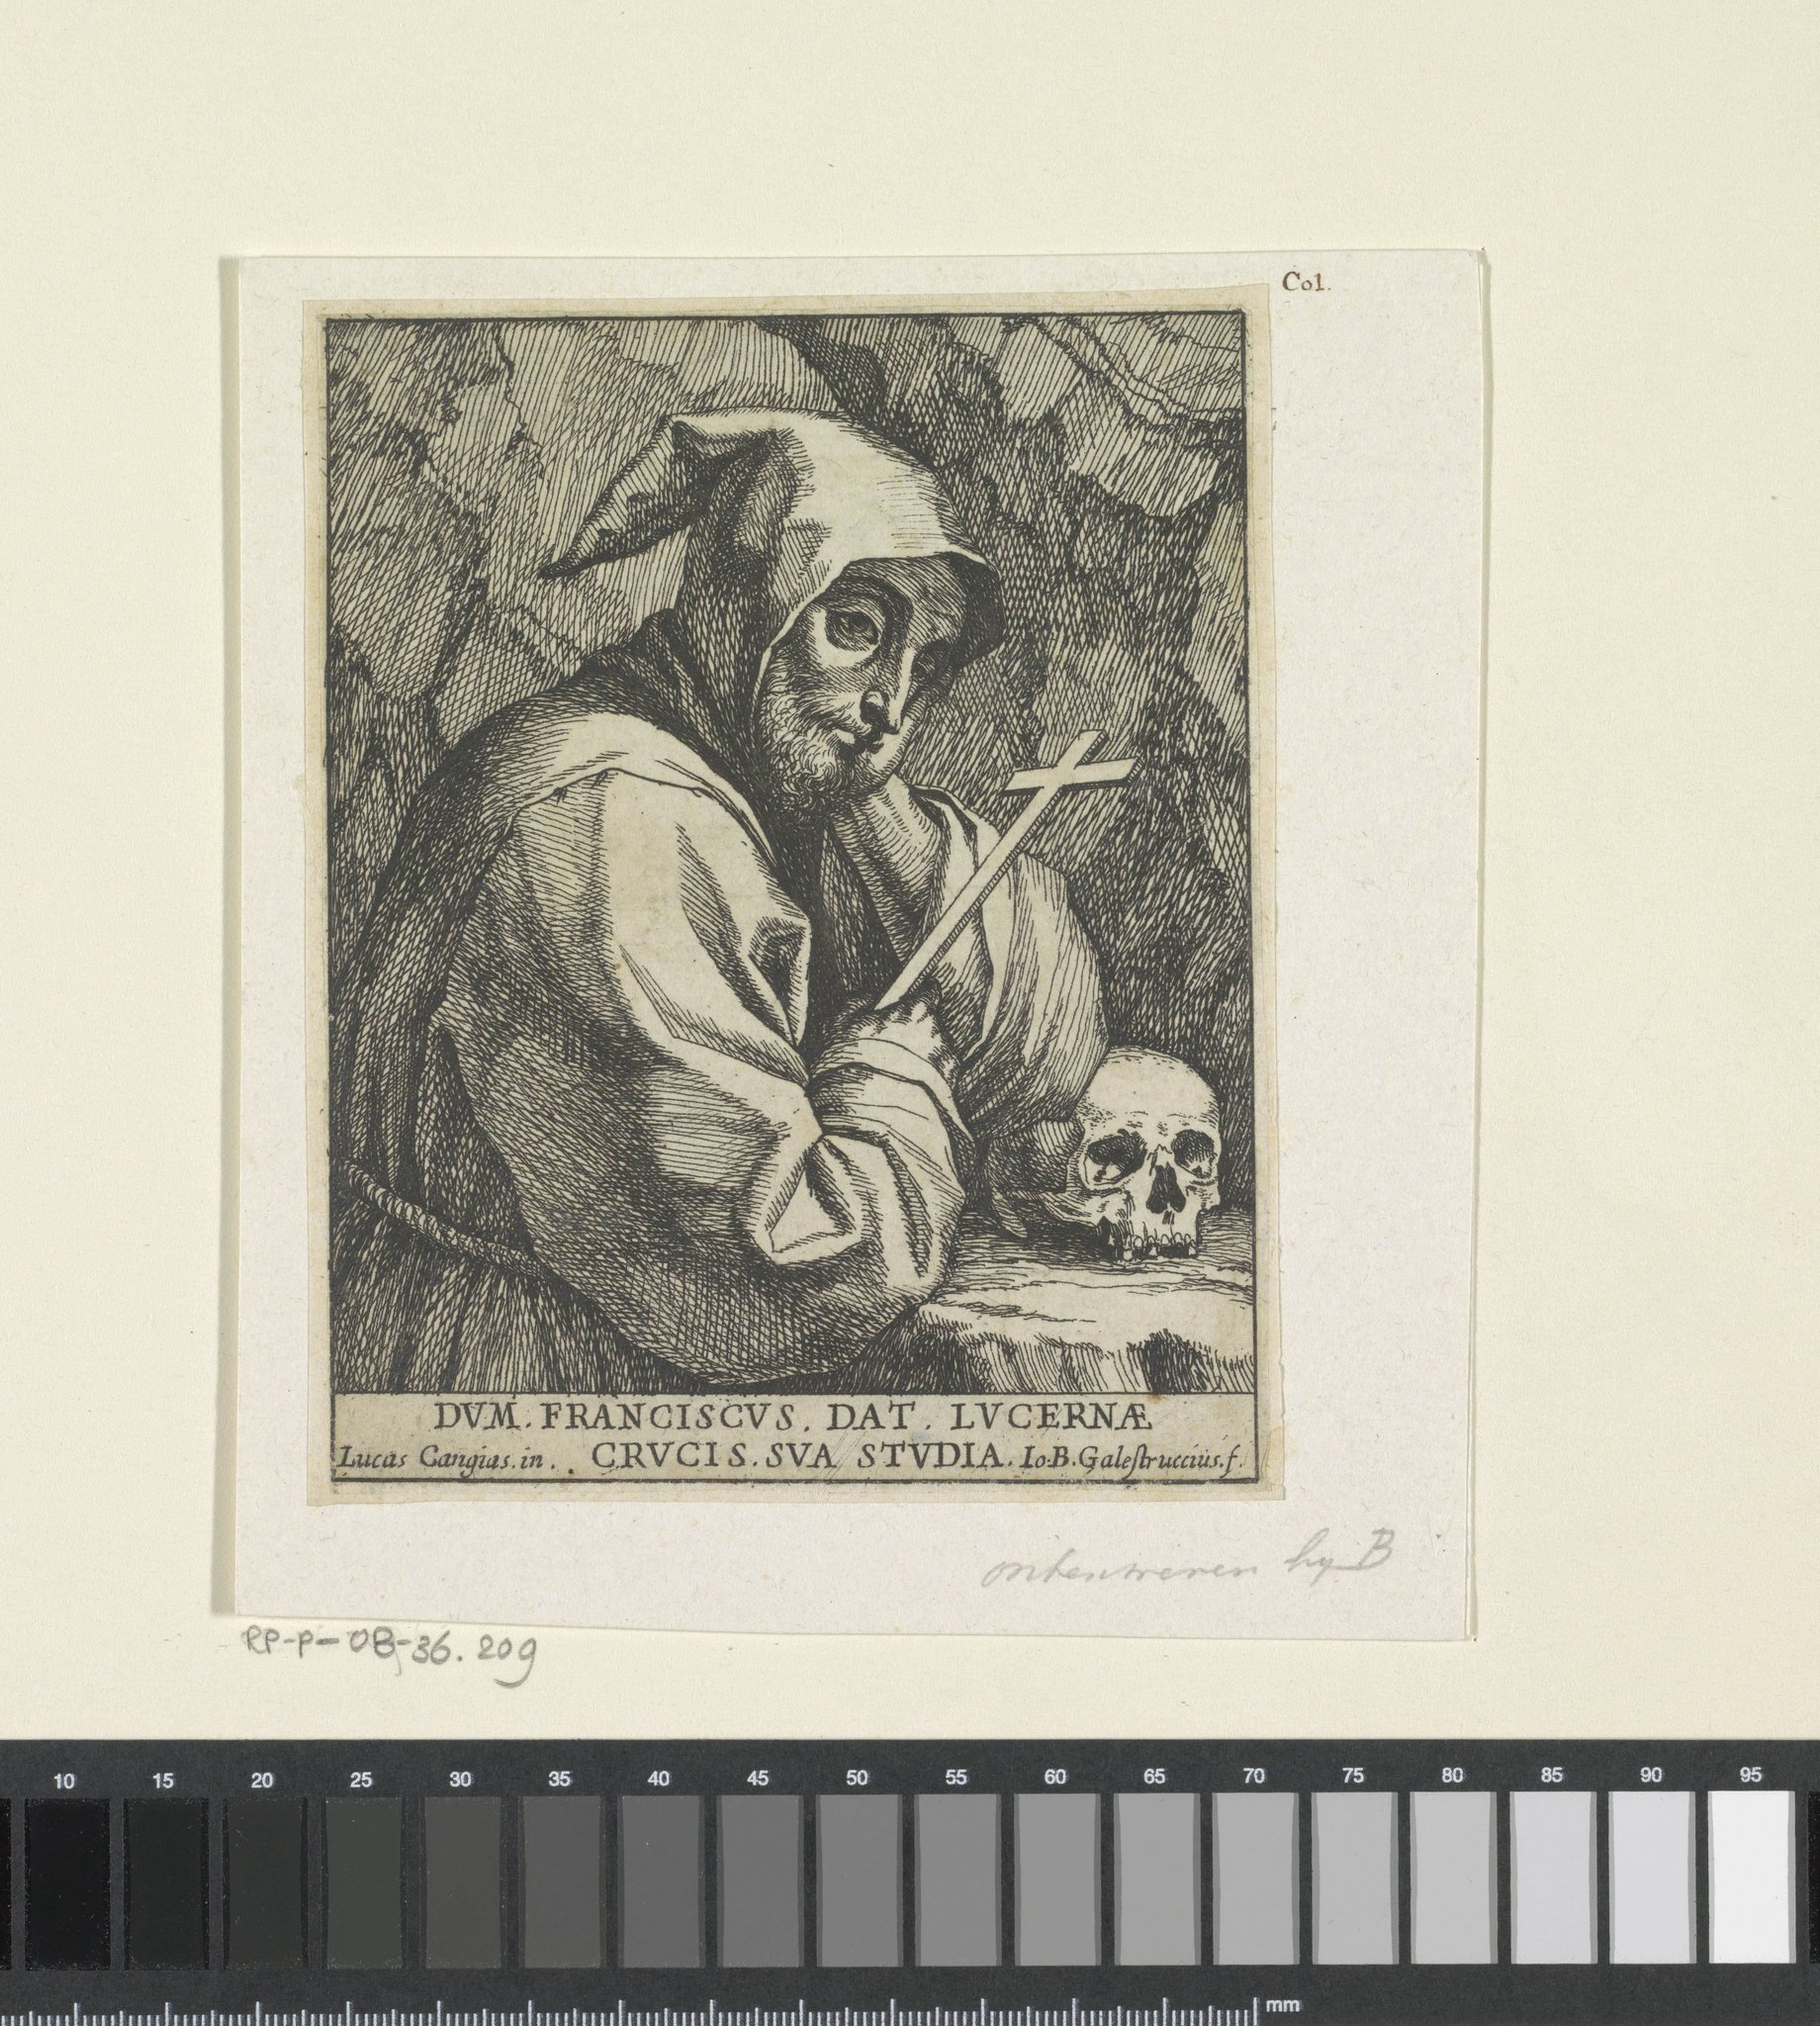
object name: print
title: Dum. Francisus. dat. Lucernae / crucis. sua studia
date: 1625-1669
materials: paper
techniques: etching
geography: italy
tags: founder of the order of friars minor (franciscans), francis(cus) of assisi; possible attributes: book, crucifix, lily, skull, stigmata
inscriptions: collector's mark: Lugt 2228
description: De heilige Franciscus met crucifix en schedel voor een rotswand.